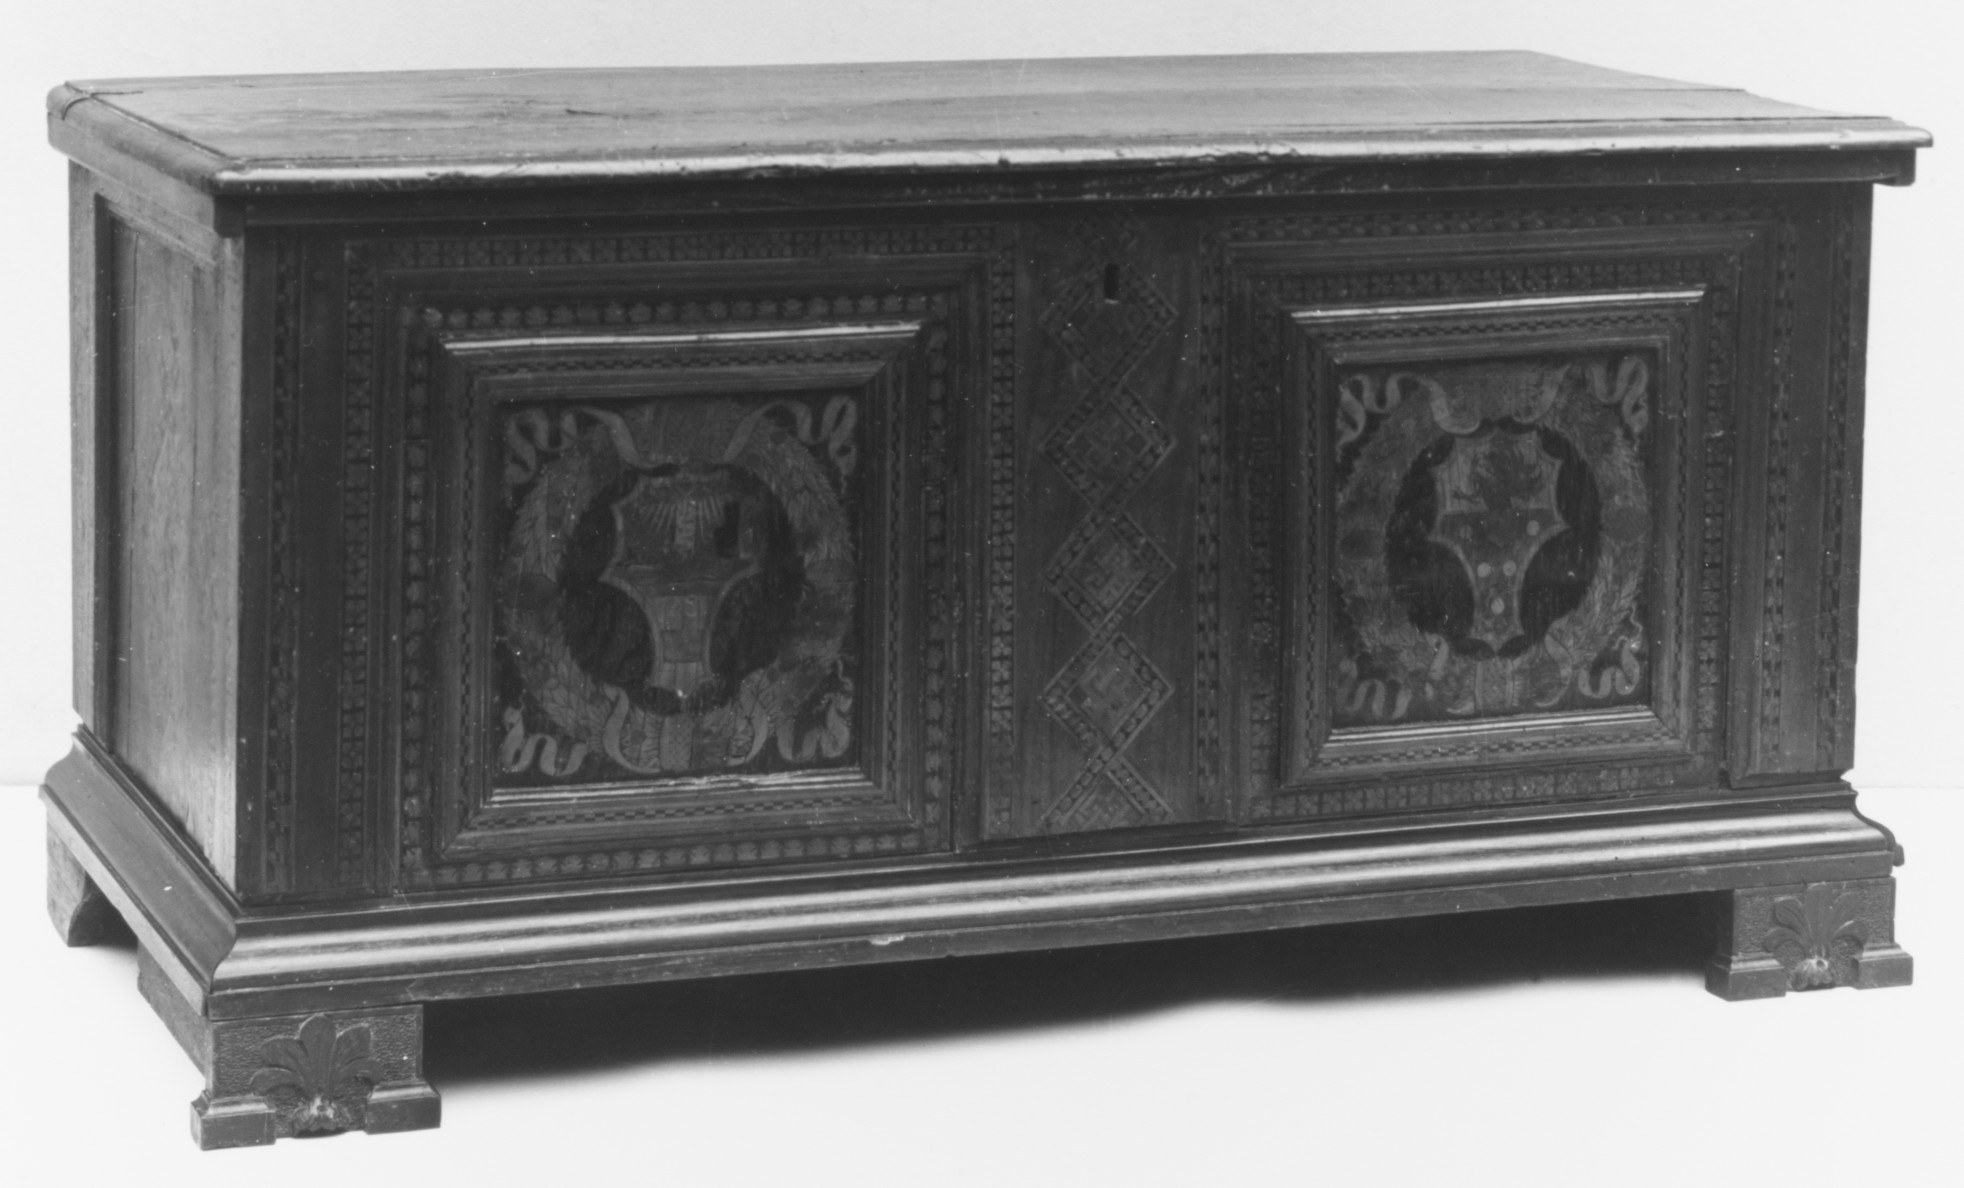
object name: cassone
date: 1467-1500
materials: wood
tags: coat of arms